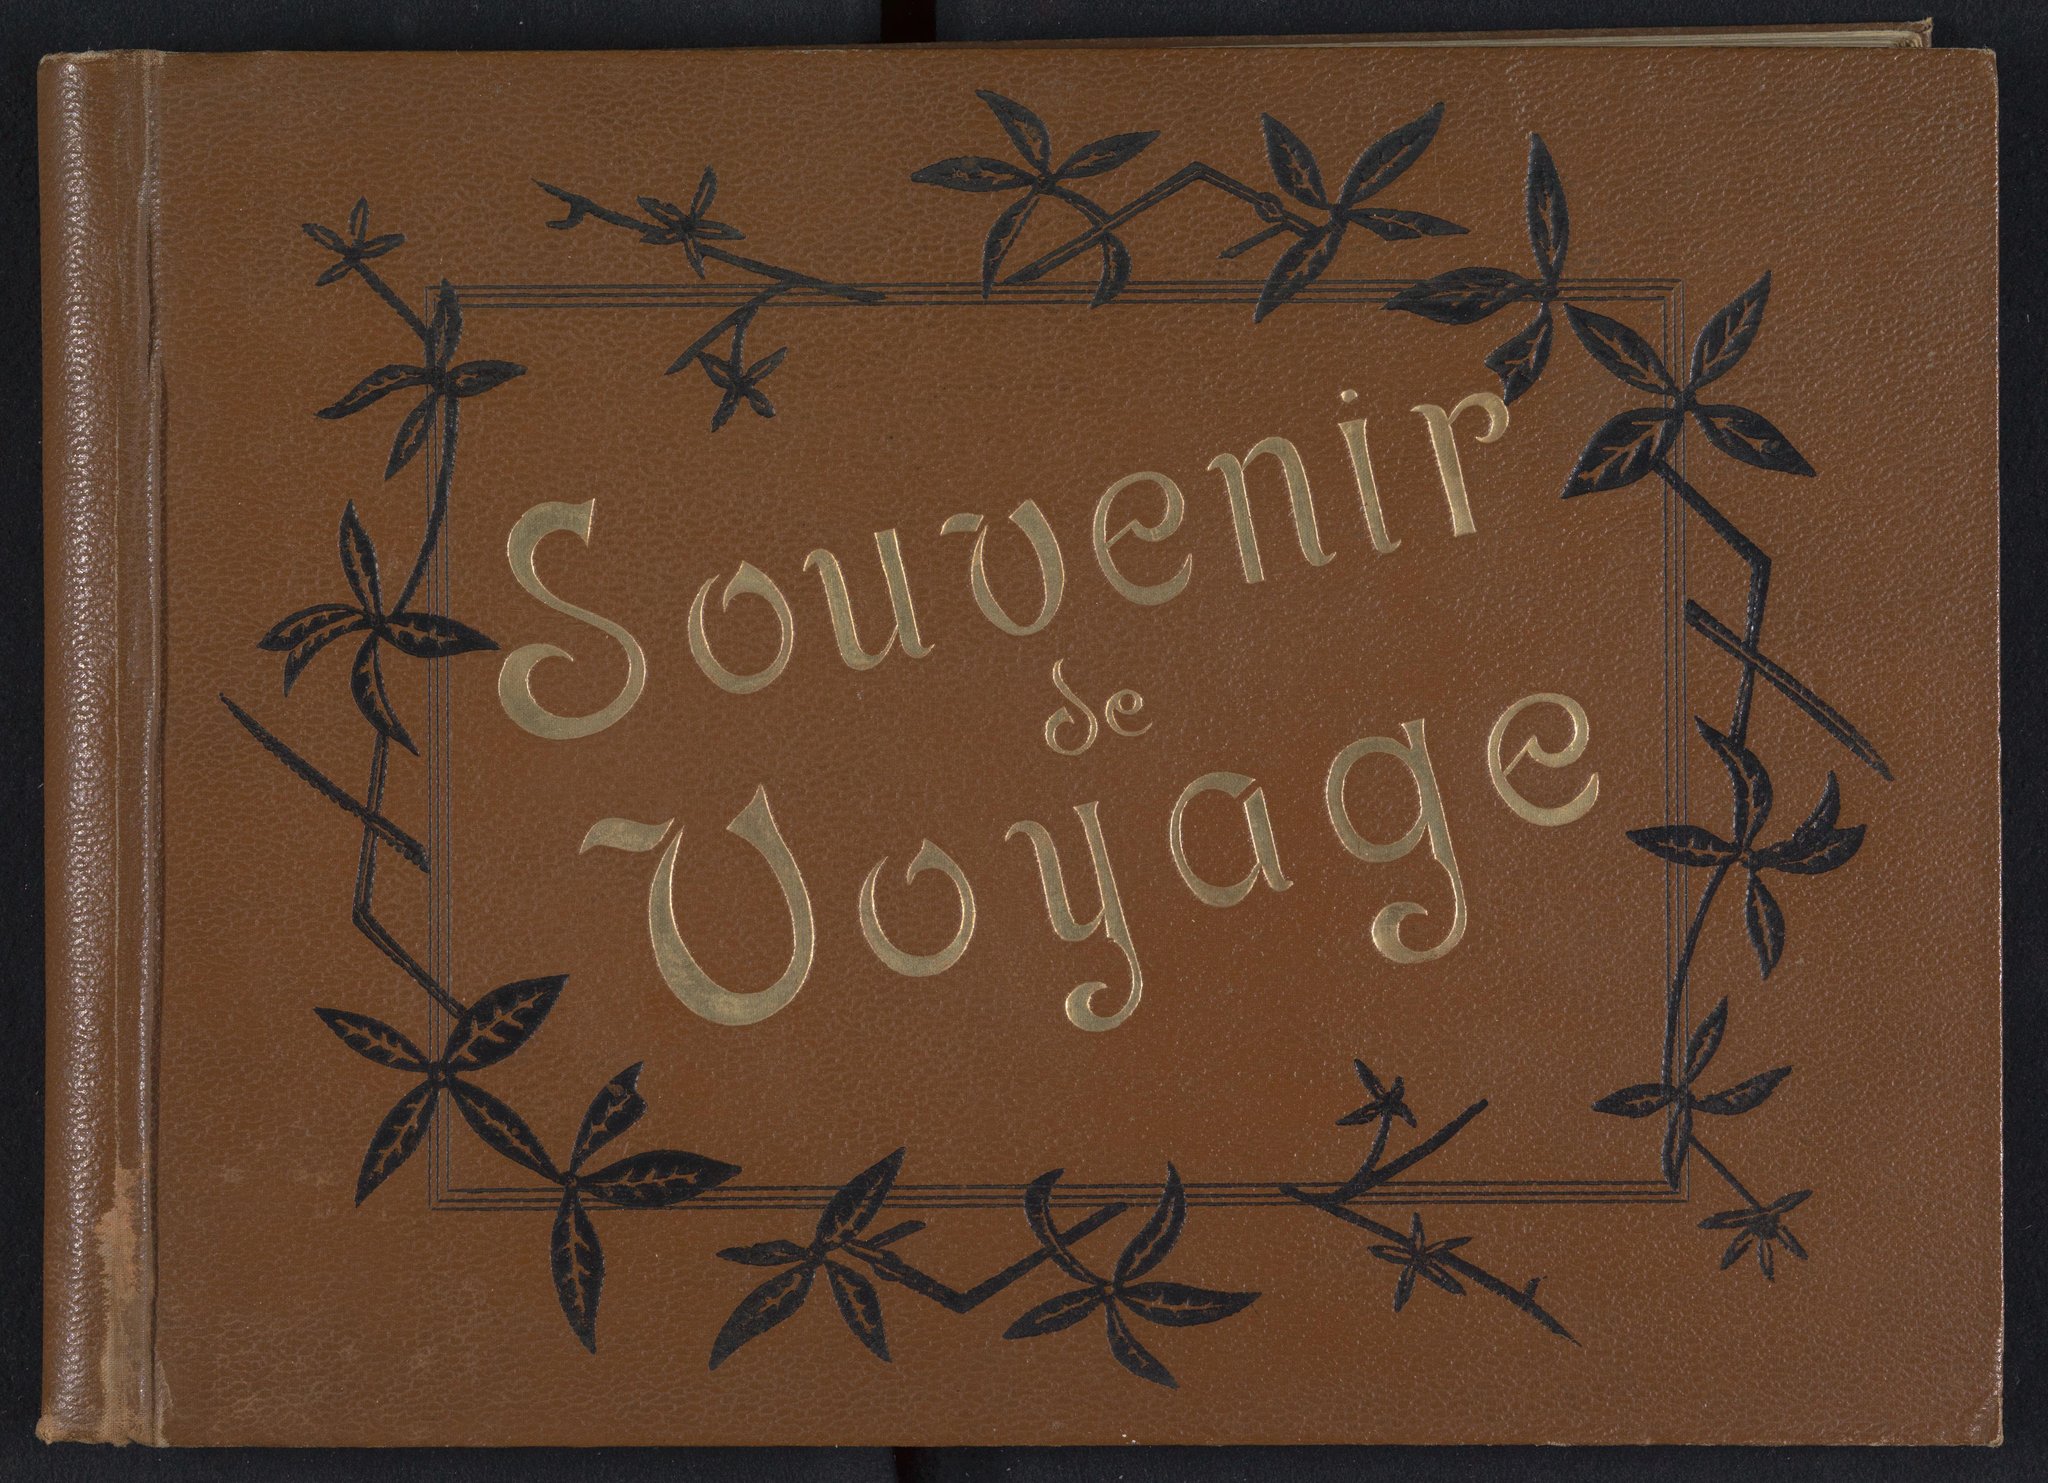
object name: slip in album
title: Fotoalbum (leeg)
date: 1860-1900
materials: cardboard, linen, paper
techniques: bookbinding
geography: leeuwarden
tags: book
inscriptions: name: ‘W. Eekhoff & Zoon Boek-Muziek-Kantoorhandel Leeuwarden’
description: Fotoalbum in bruine band met op het voorplat de titel in gouddruk en in reliëf. Het achterplat is versierd met een bladmotief in reliëf. Het album bevat 47 bladen met plaats voor diverse formaten foto's.